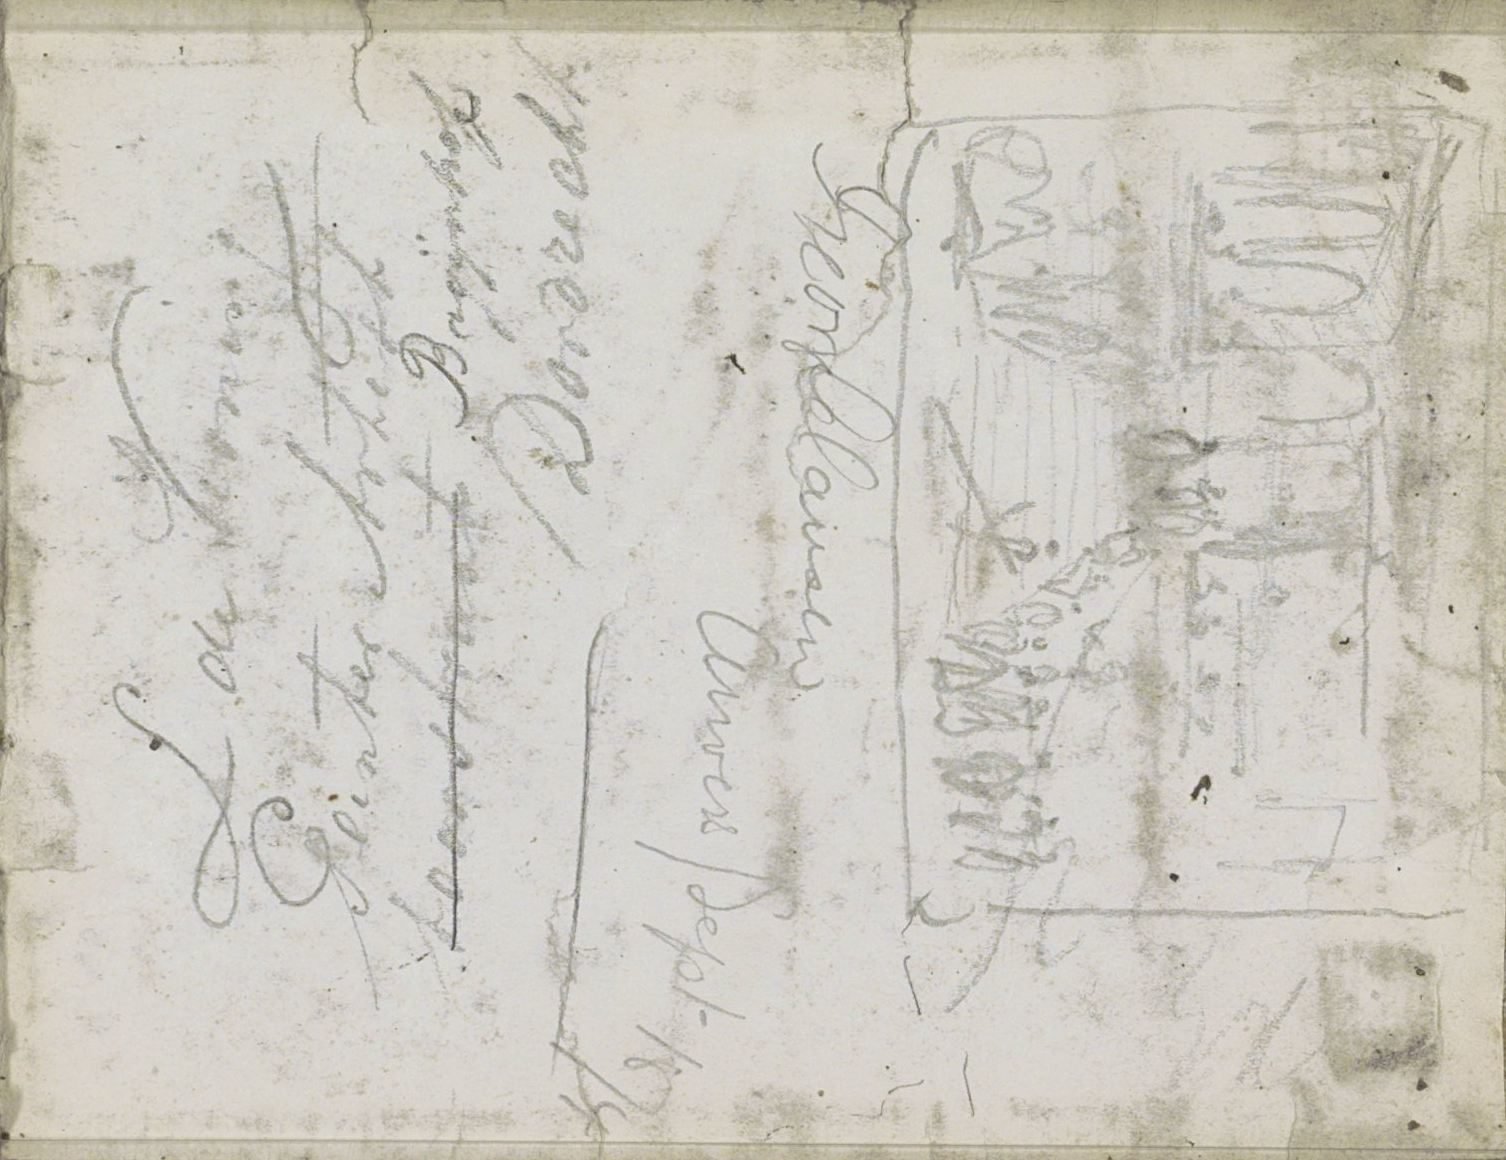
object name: sketchbook leaf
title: Figuren op een trap bij een arcade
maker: george clausen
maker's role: draughtsman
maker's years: 1852-1912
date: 1809-1874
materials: paper, pencil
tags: standing figure, flight of steps, arcade ~ architecture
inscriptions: date and inscription: ‘L. De Koning/ [...]inter [...]est/ Begijnhof/ Dordrecht/ George lave[...]n Anvers Sept 1874’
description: Achterste schutblad uit een schetsboek met 37 bladen.